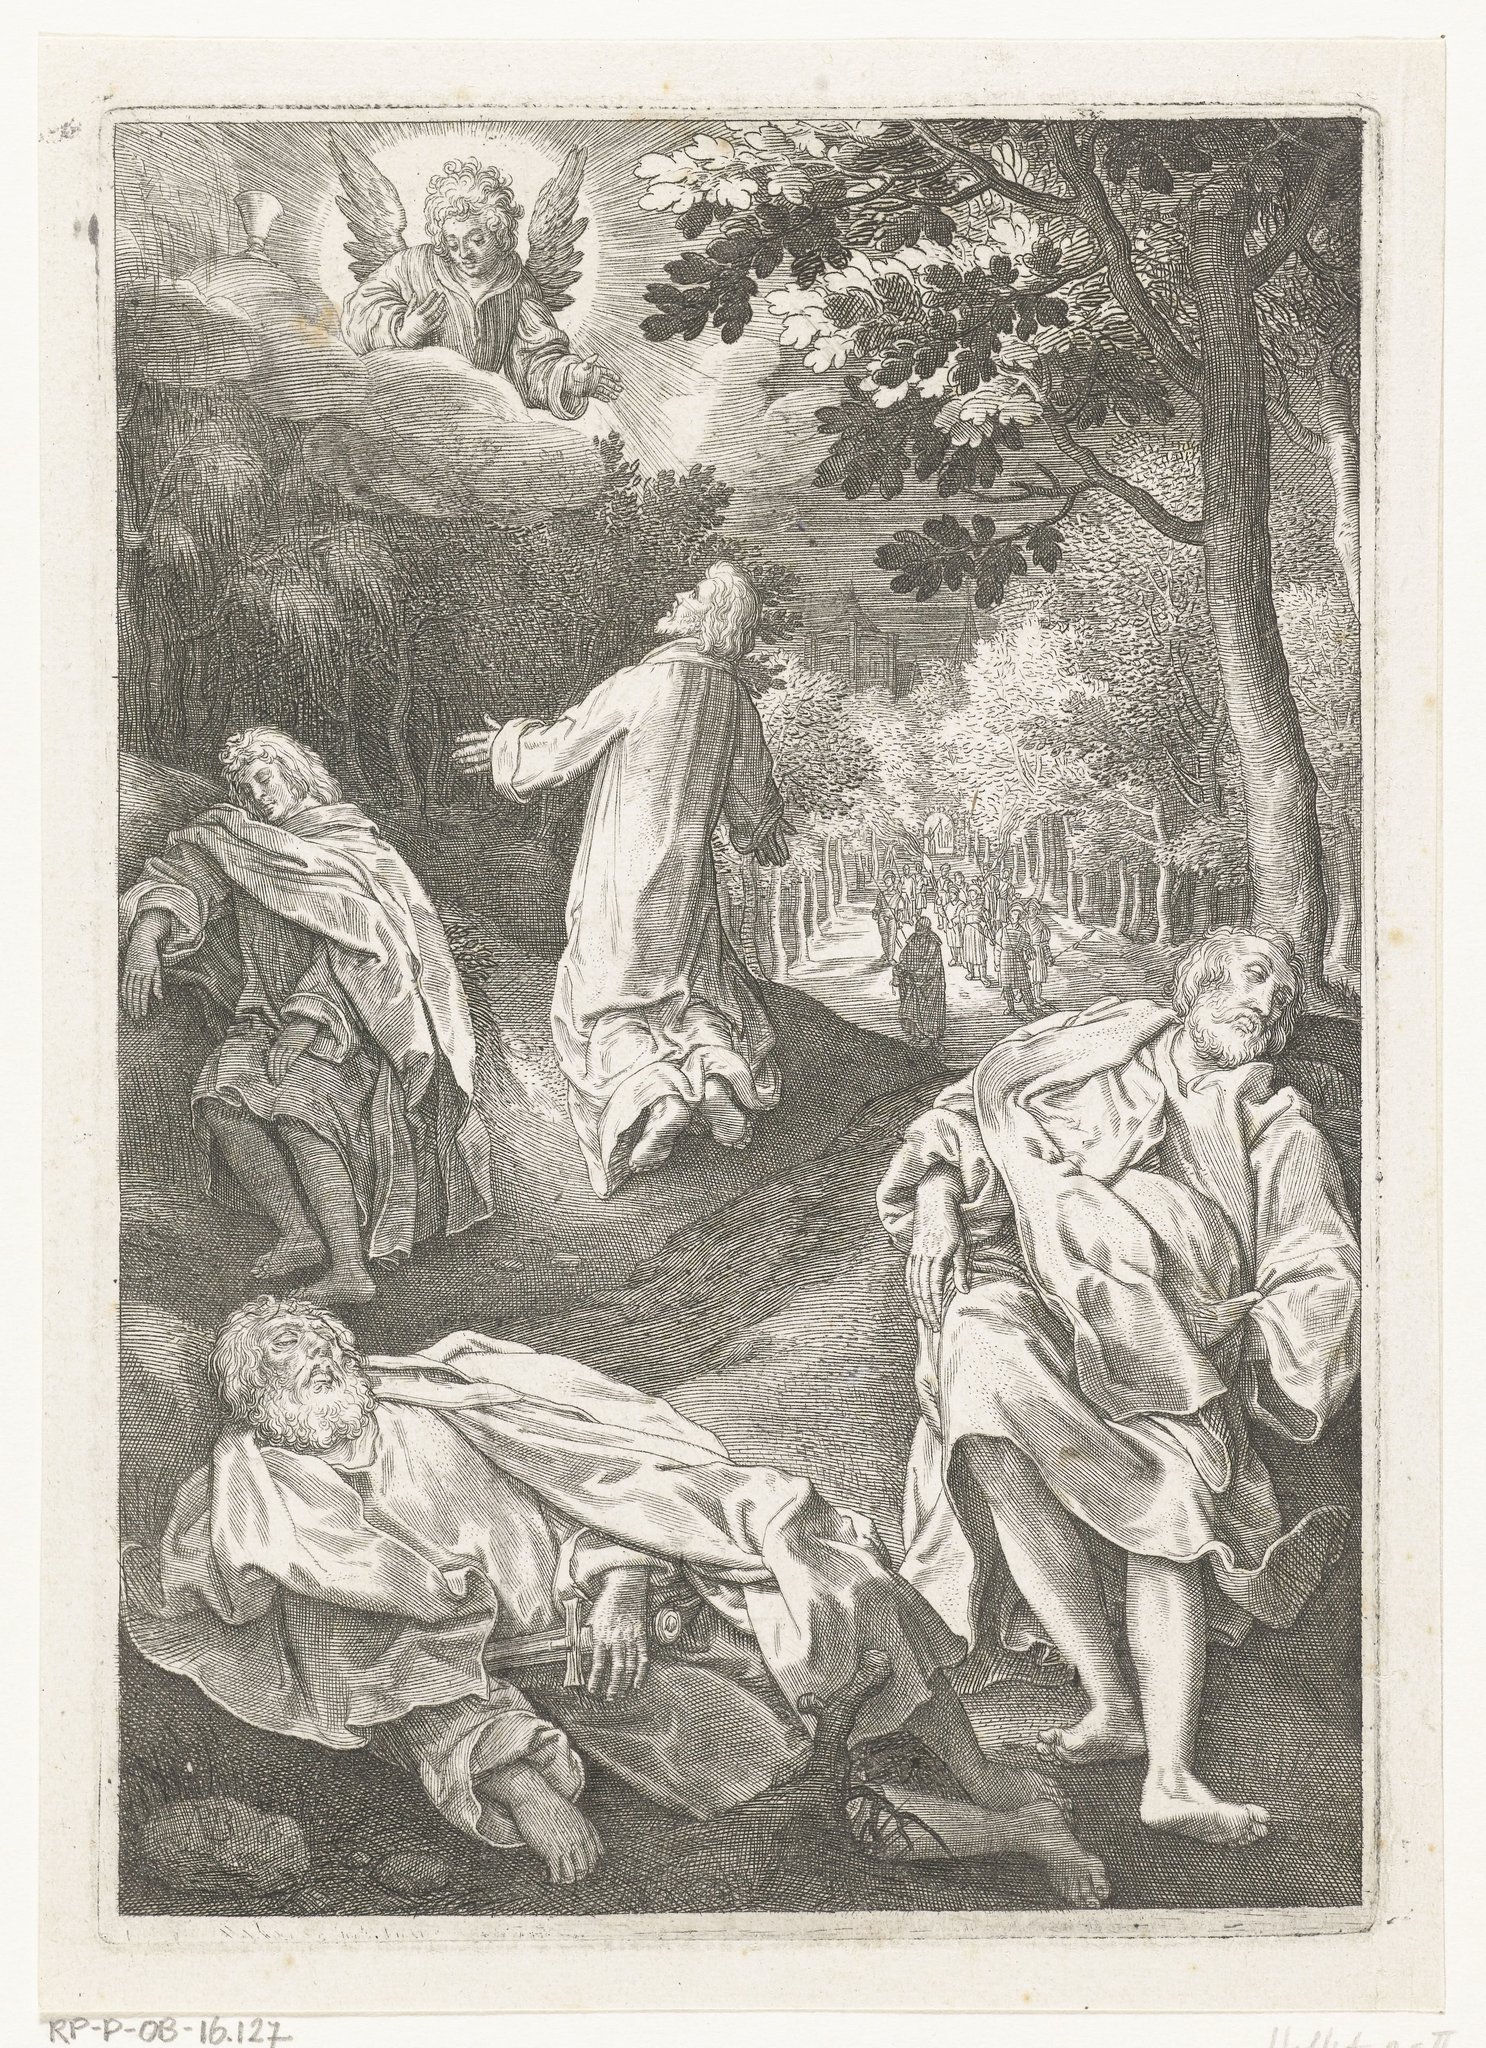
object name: print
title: Christus in de hof van Gethsemane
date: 1618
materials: paper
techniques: engraving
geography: netherlands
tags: christ's prayer in the garden of gethsemane during the night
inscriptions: date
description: Een engel verschijnt voor Christus op de Olijfberg om hem kracht te geven. Christus knielt in gebed en kijkt omhoog, hij wordt omringd door zijn slapende discipelen Petrus, Jakobus en Johannes.